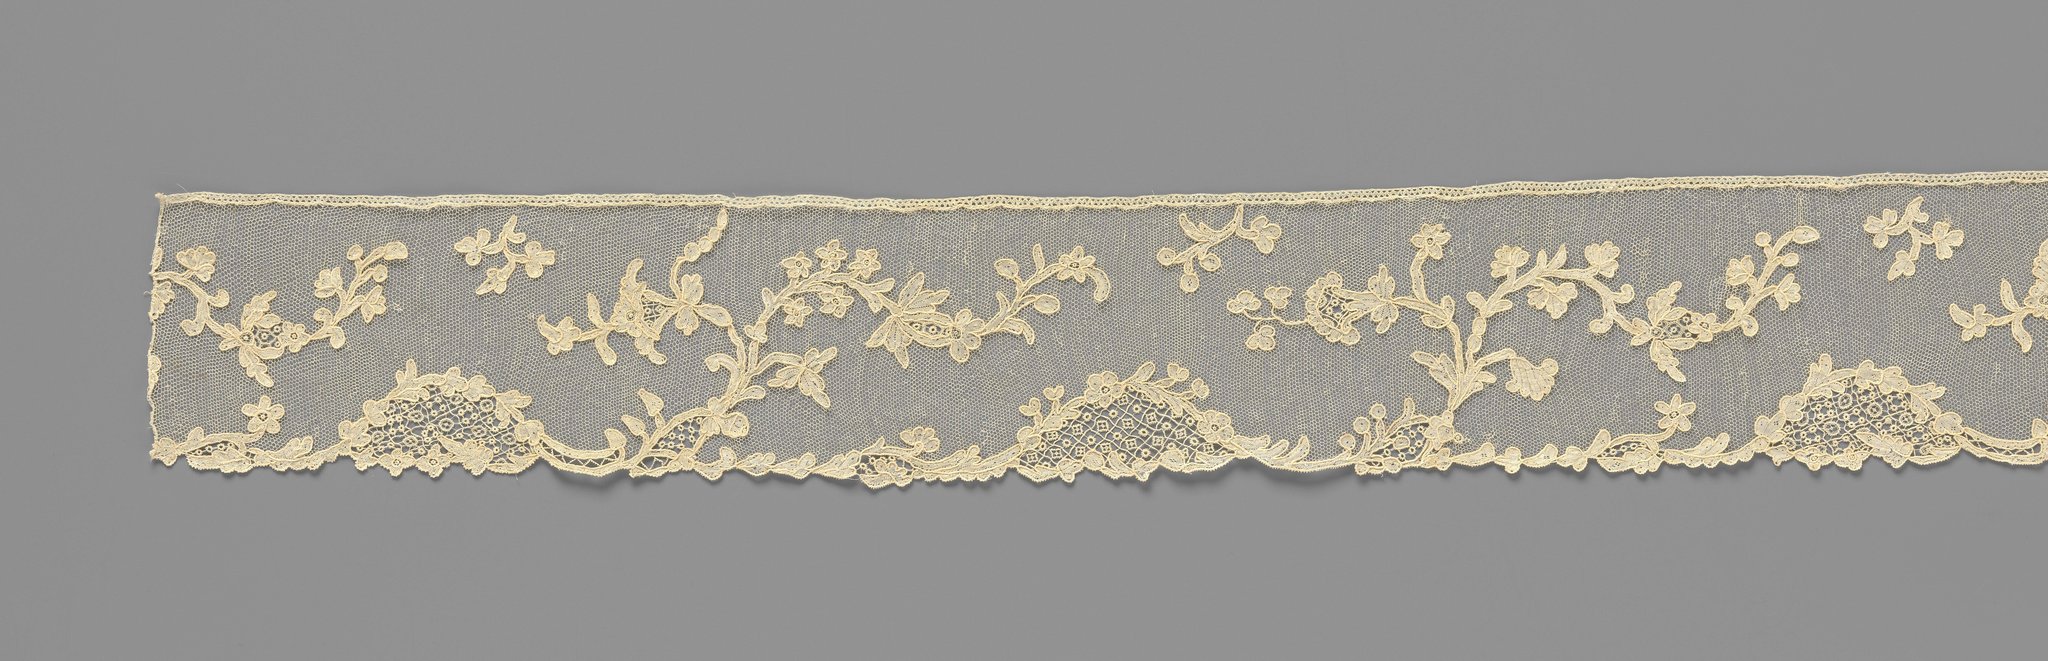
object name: strip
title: Strook naaldkant met opgevulde halve ovalen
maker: Anonymous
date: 1750-1774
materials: linen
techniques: lace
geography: alençon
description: Strook naturelkleurige naaldkant: Alençon-kant. Patroon met een repetitief motief van twee verschillende, gespleten bloemtakken op een fijne zeshoekige maasgrond, een Alençon-grond. Tussen deze takken hangt steeds een kleinere takje, afwisselend met bloemen en bloemknoppen of bessen. De onderrand wordt gevormd door een golvende rank met bladeren en enkele bloemen. De golven vormen grote halve ovalen langs de onderrand. Deze zijn opgevuld met een siergrond met verschillende (rader)picots. De bovenzijde is afgezet met een geklost bandje.